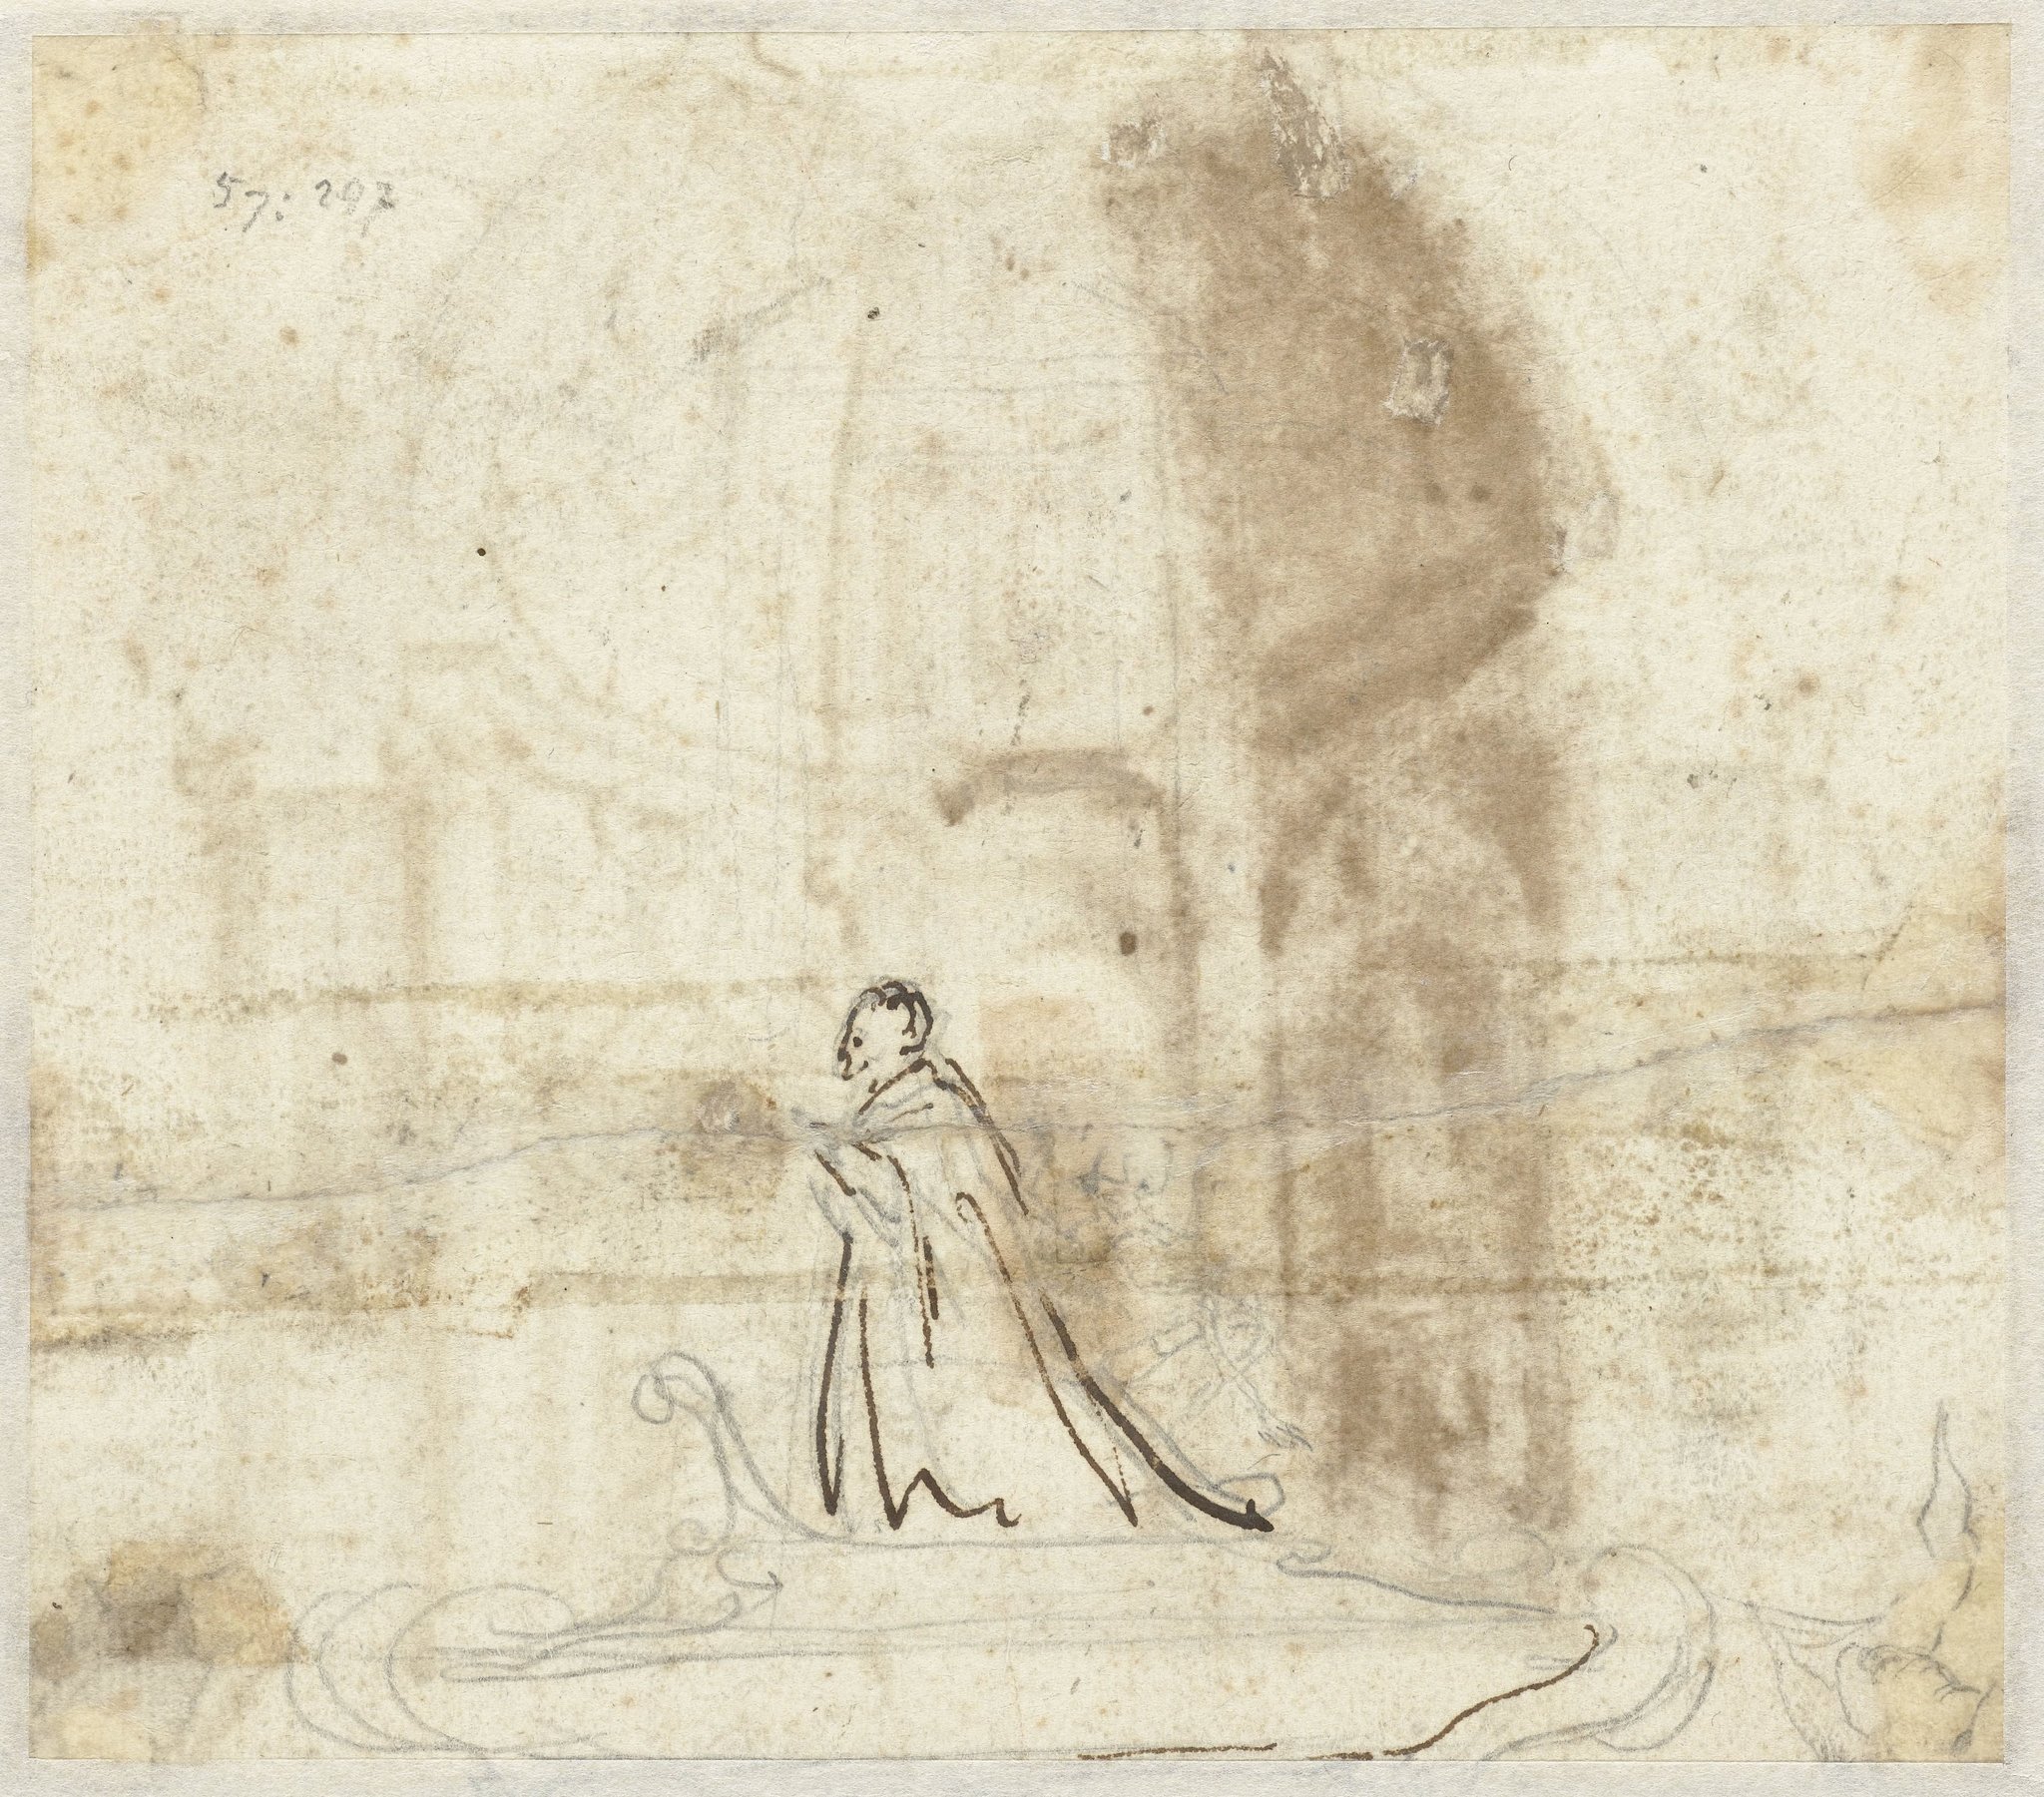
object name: design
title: Ontwerp voor een tombe van een grafkapel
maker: cigoli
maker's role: draughtsman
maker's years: 1559-1613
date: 1590-1640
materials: ink, paper, pencil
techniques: pen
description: Ontwerp voor een tombe van een grafkapel met de priant in een vluchtige schets.